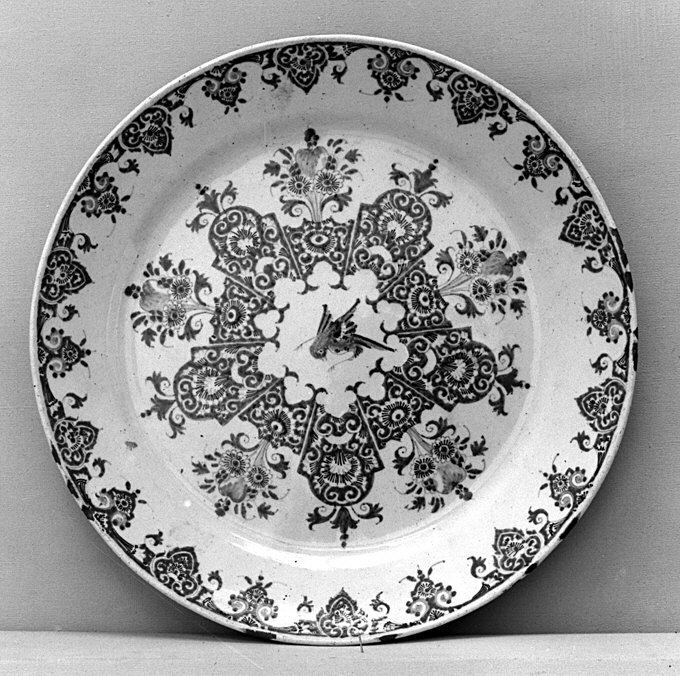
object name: plate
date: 1725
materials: faience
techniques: glazing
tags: birds,flowers